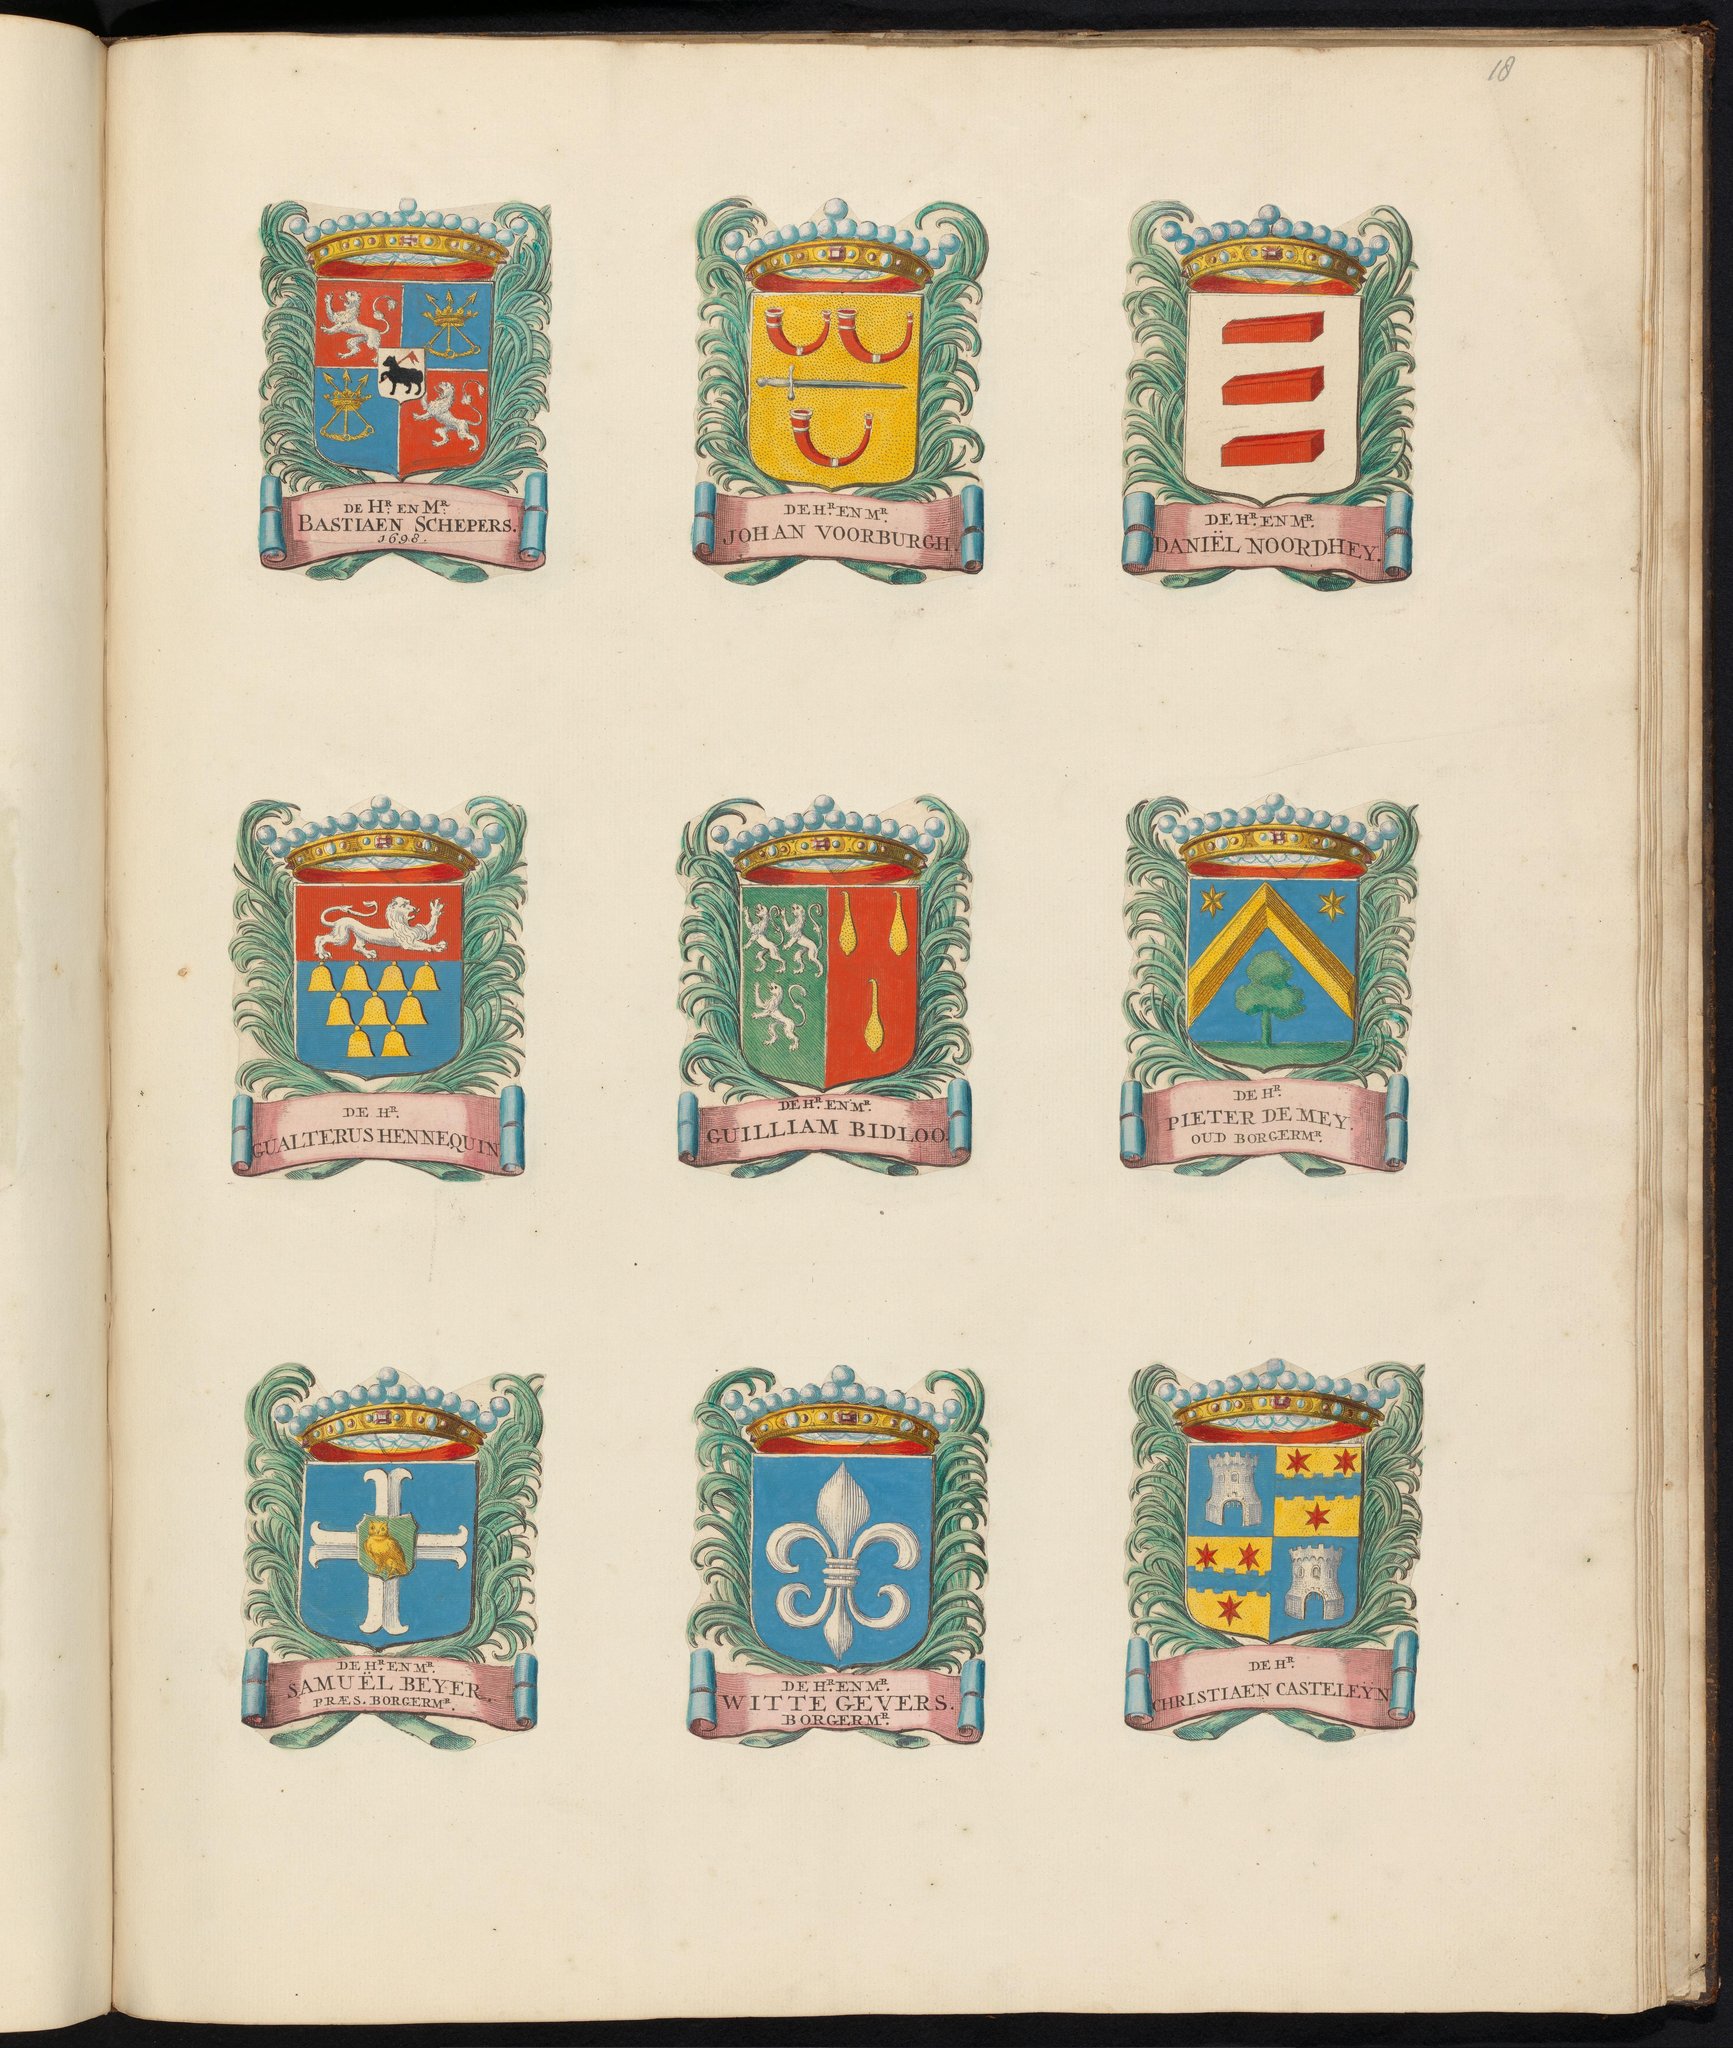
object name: album leaf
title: Caart van de stad Rotterdam (...)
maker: Anonymous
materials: paper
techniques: colour, etching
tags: delfshaven, coat of arms (as symbol of the state, etc.), rotterdam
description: Negen voorstellingen op een albumblad. Het betreft negen wapen van raden in de vroedschap van Rotterdam. De prenten zijn onderdeel van de kaart van Rotterdam door Johannes de Vouw en maken deel uit van een album.